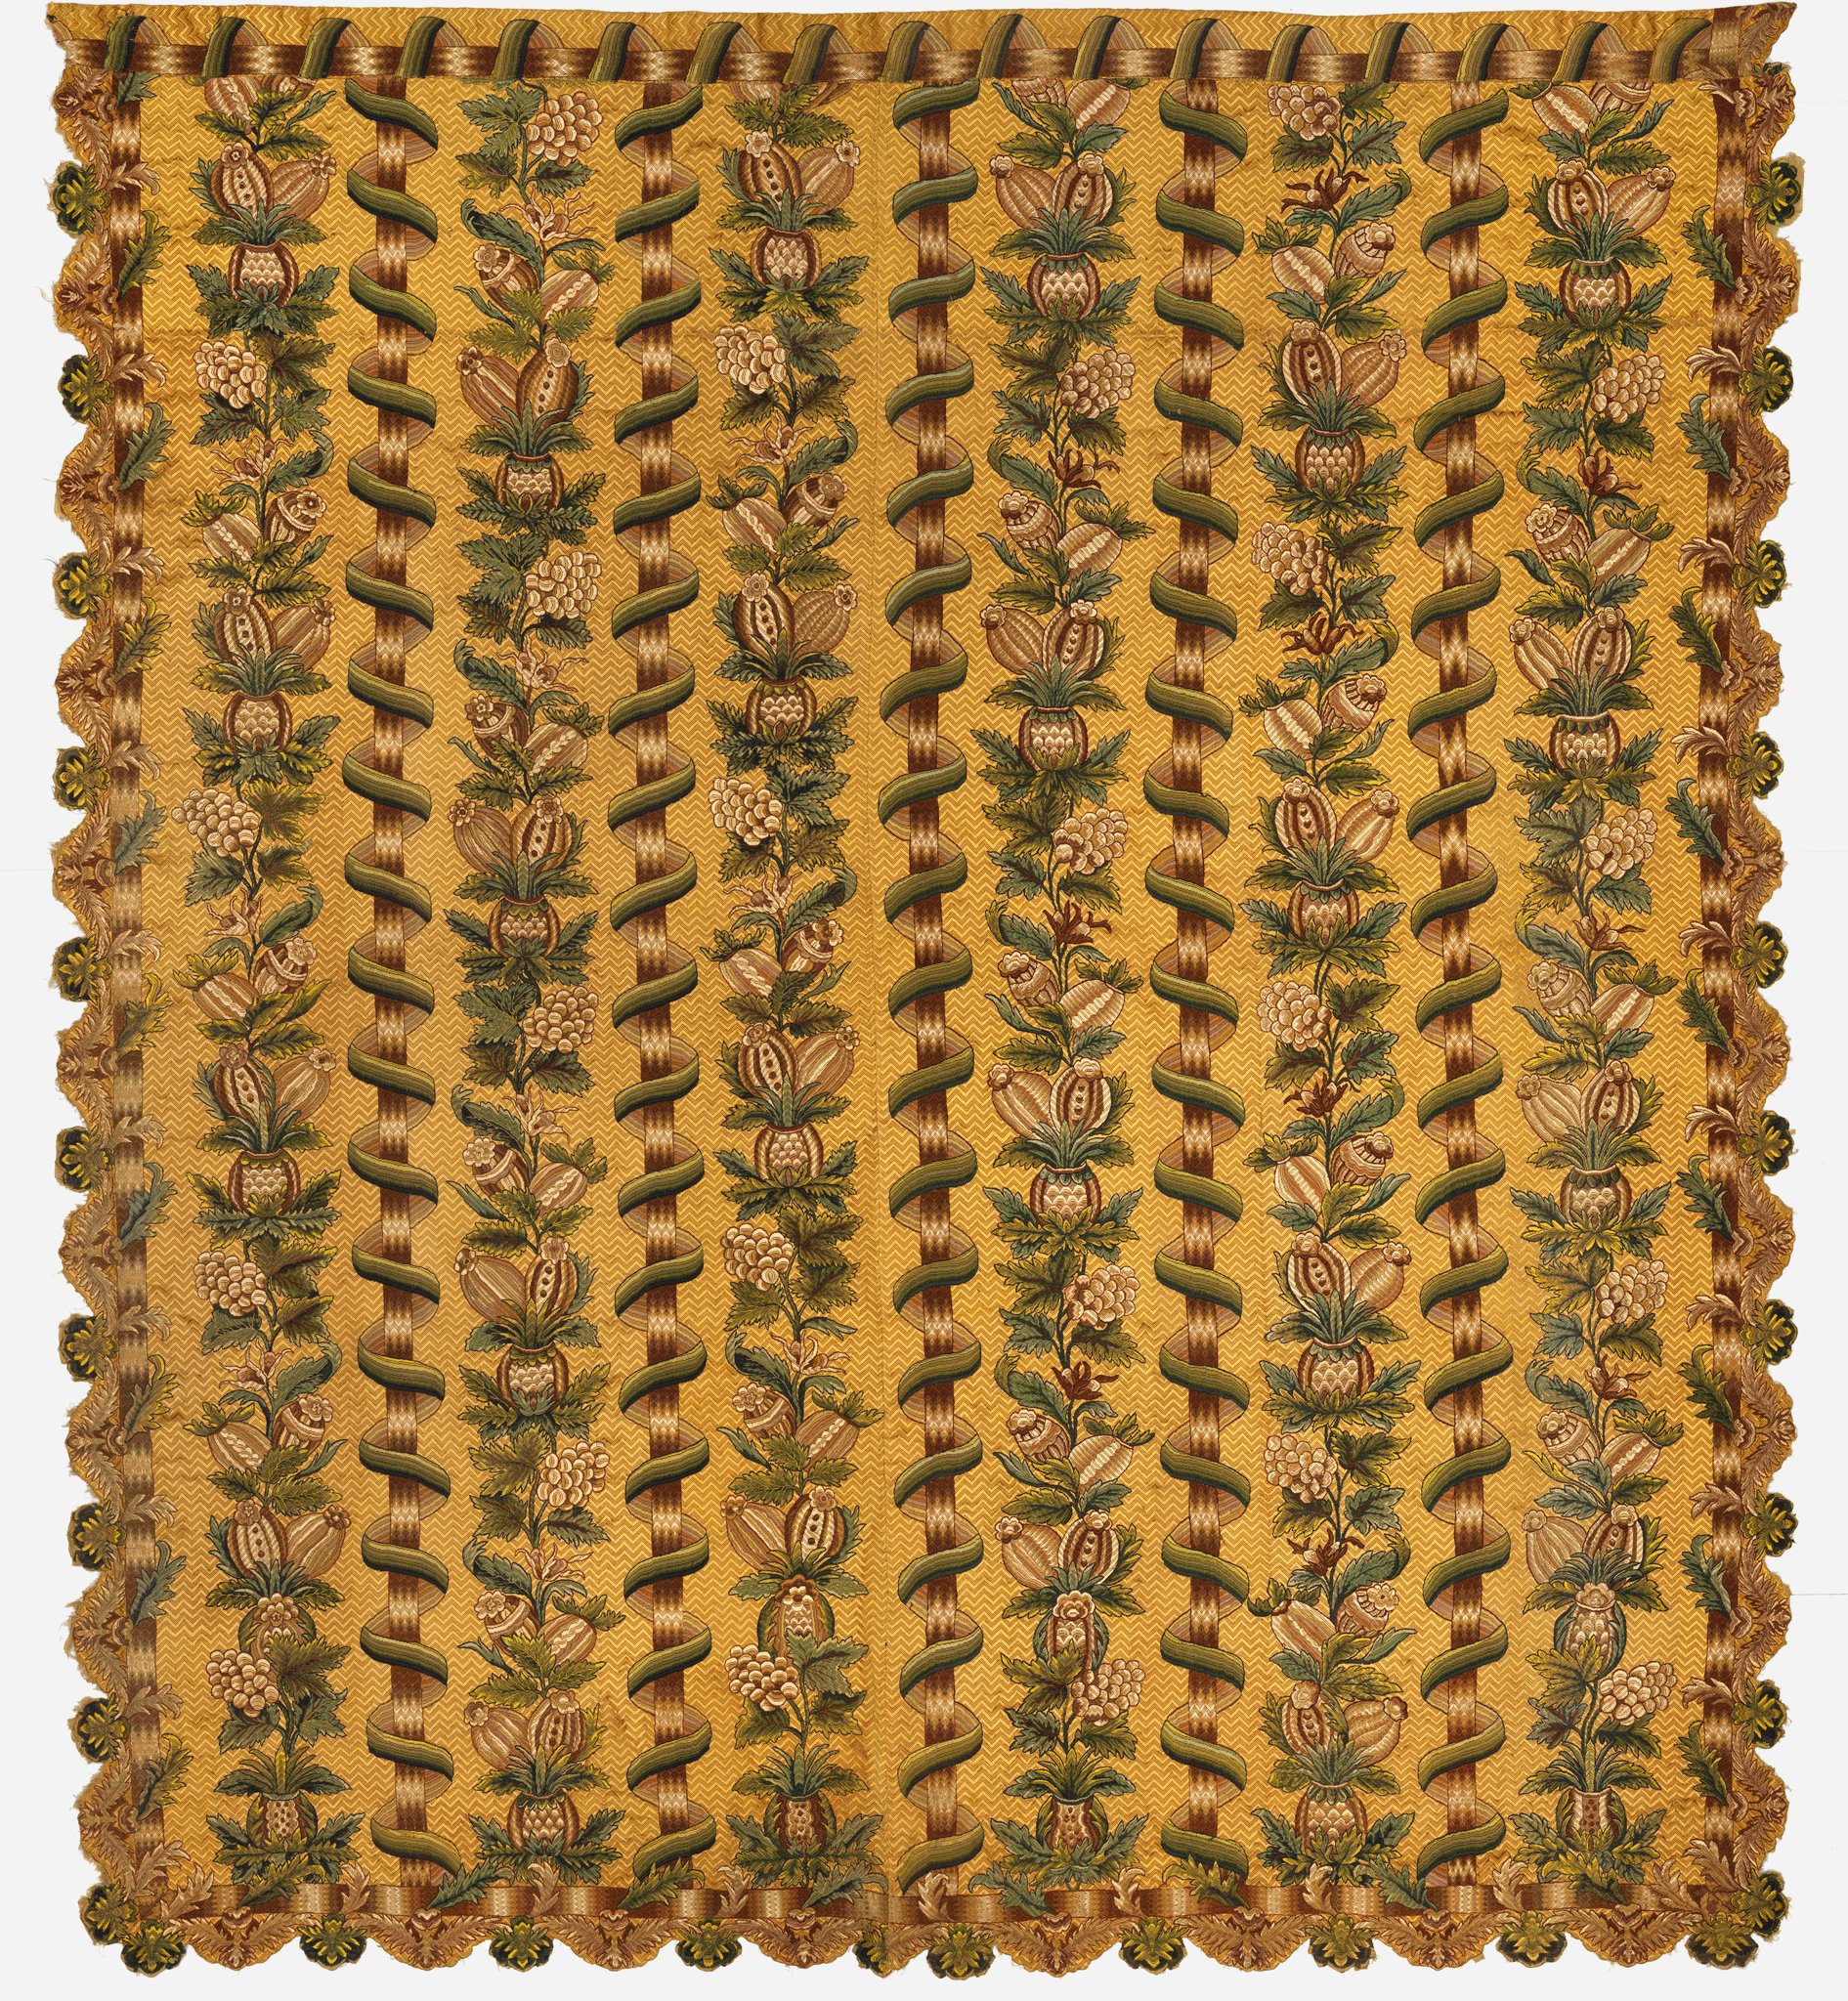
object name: bed curtain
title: Gordijn voor hemelbed van point de Hongria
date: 1700-1725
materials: linen, silk, wool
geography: england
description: Gordijn voor hemelbed van point de Hongria. Techniek: op een stramien van linnen is een vol borduursel in wol en zijde aangebracht in verticale platsteek, zowel ingrijpend als met zig-zag intervallen. Patroon: op een gele fond met zig-zag effect staat vijf maal een paal met spiraalband, afgewisseld door een rechtopgaande tak met bladeren en dikke vruchten: granaatappels in verscheiden soorten en druivetrossen, genuanceerd van groen, bruin, blauw en wit en vloeiend van licht naar donker. De paal met spiraal heeft een bliksemschichtpatroon. Links, rechts en onderaan is de paal met een bladspiraal omwonden. Boven aan is aangezet een in de lengte doorsneden driekwart paal met spiraalband. Aan drie zijden afgewerkt met schulpen. Een middennaad wijst op latere vormwijziging.